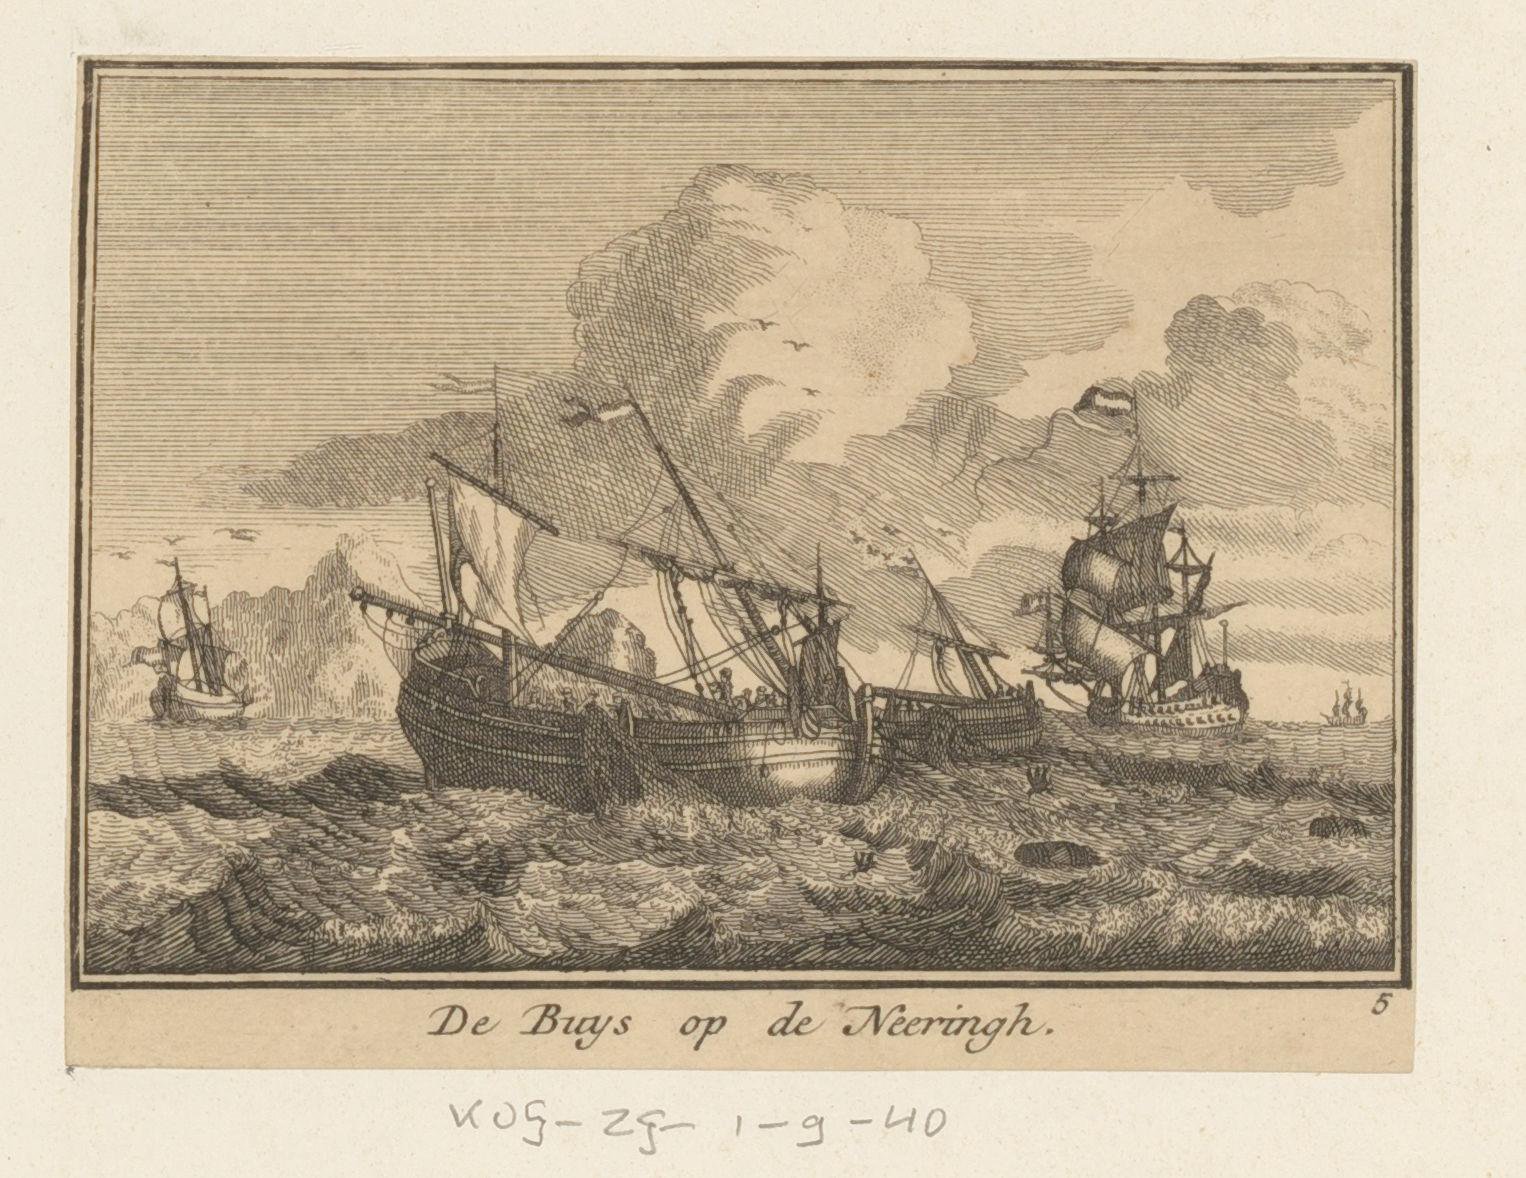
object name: print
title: De Buys op de Neeringh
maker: Anonymous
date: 1728-1775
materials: paper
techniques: engraving, etching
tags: harbour, fishing net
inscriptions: collector's mark: Lugt 1641, stamp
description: Prenten zijn een verkleinde versie van de serie Groote Visserij, Visschers Atlas tot Amsterdam. Prenten door Adolf van der Laan, naar tekeningen van Sieuwert van der Meulen en uitgegeven door Pieter Schenk II. De serie bestaat uit zeventien platen over de haringvisserij en zestien platen over de walvisvangst. De serie is waarschijnlijk rond 1720 uitgegeven. De kleine prenten werden met vier voorstellingen op een plaat gedrukt. Elke afbeelding werd genummerd.